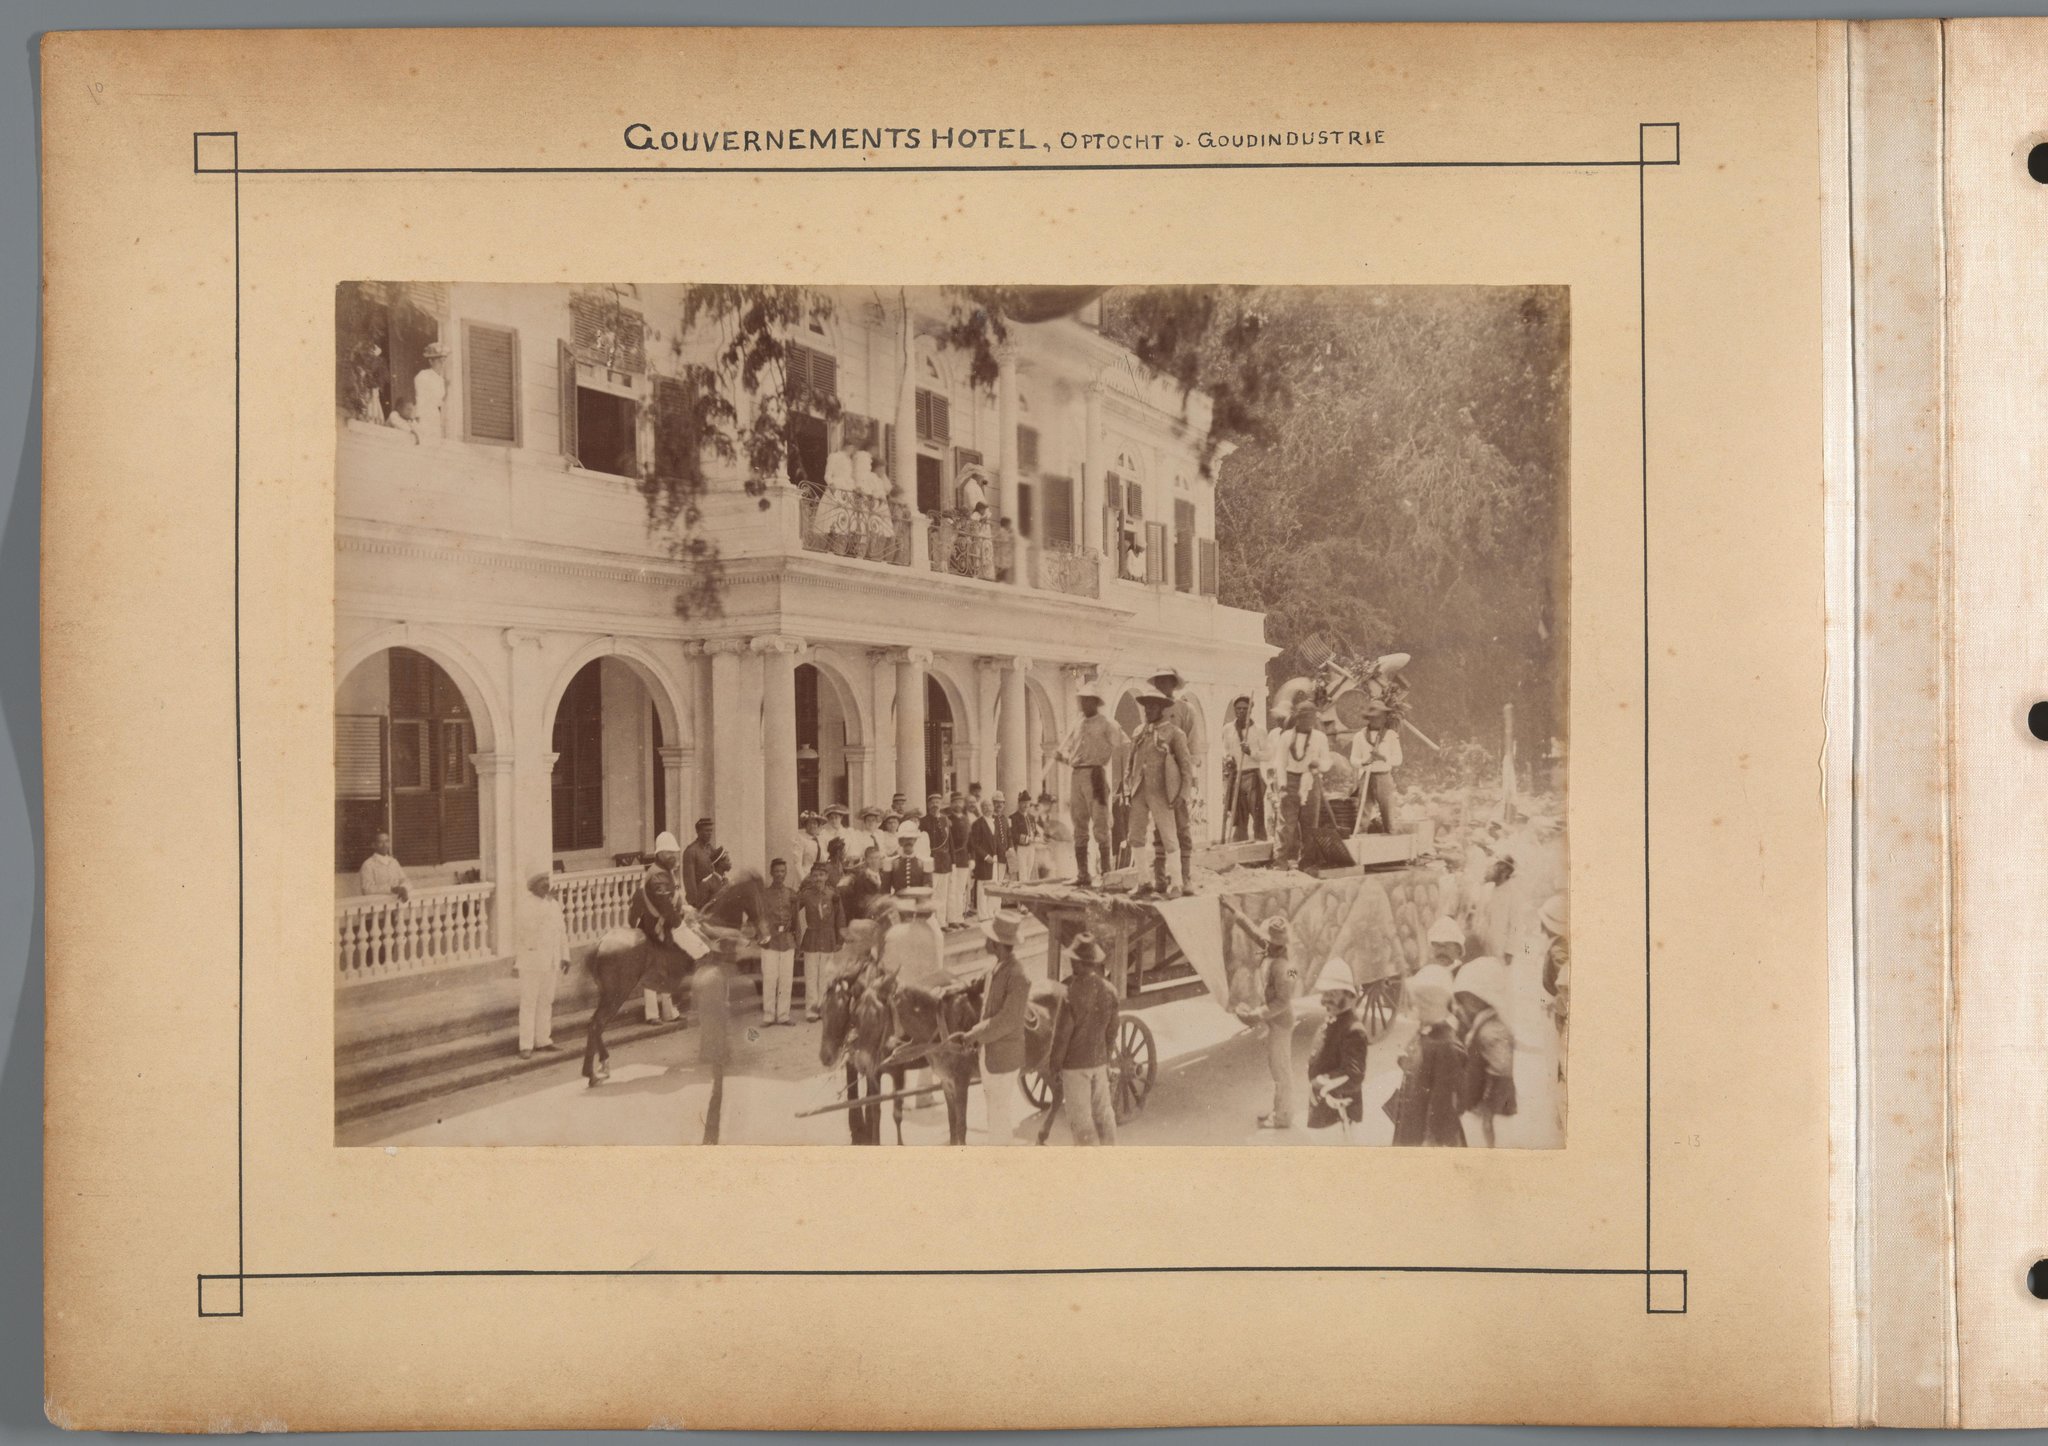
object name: photograph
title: Gouvernements Hotel, optocht d. Goudindustrie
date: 1898-1902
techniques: albumen print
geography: suriname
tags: suriname